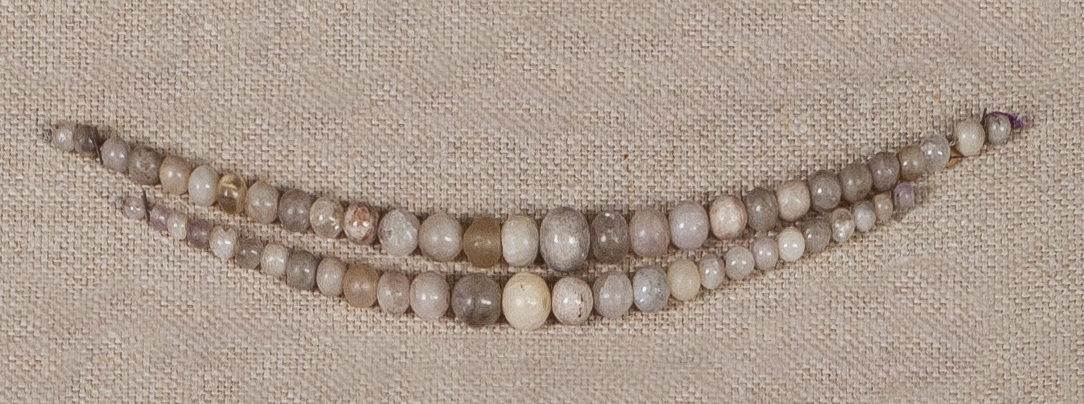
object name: necklace, bead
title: String of Ball Beads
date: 1981-1295 BCE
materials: crystal, quartz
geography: egypt